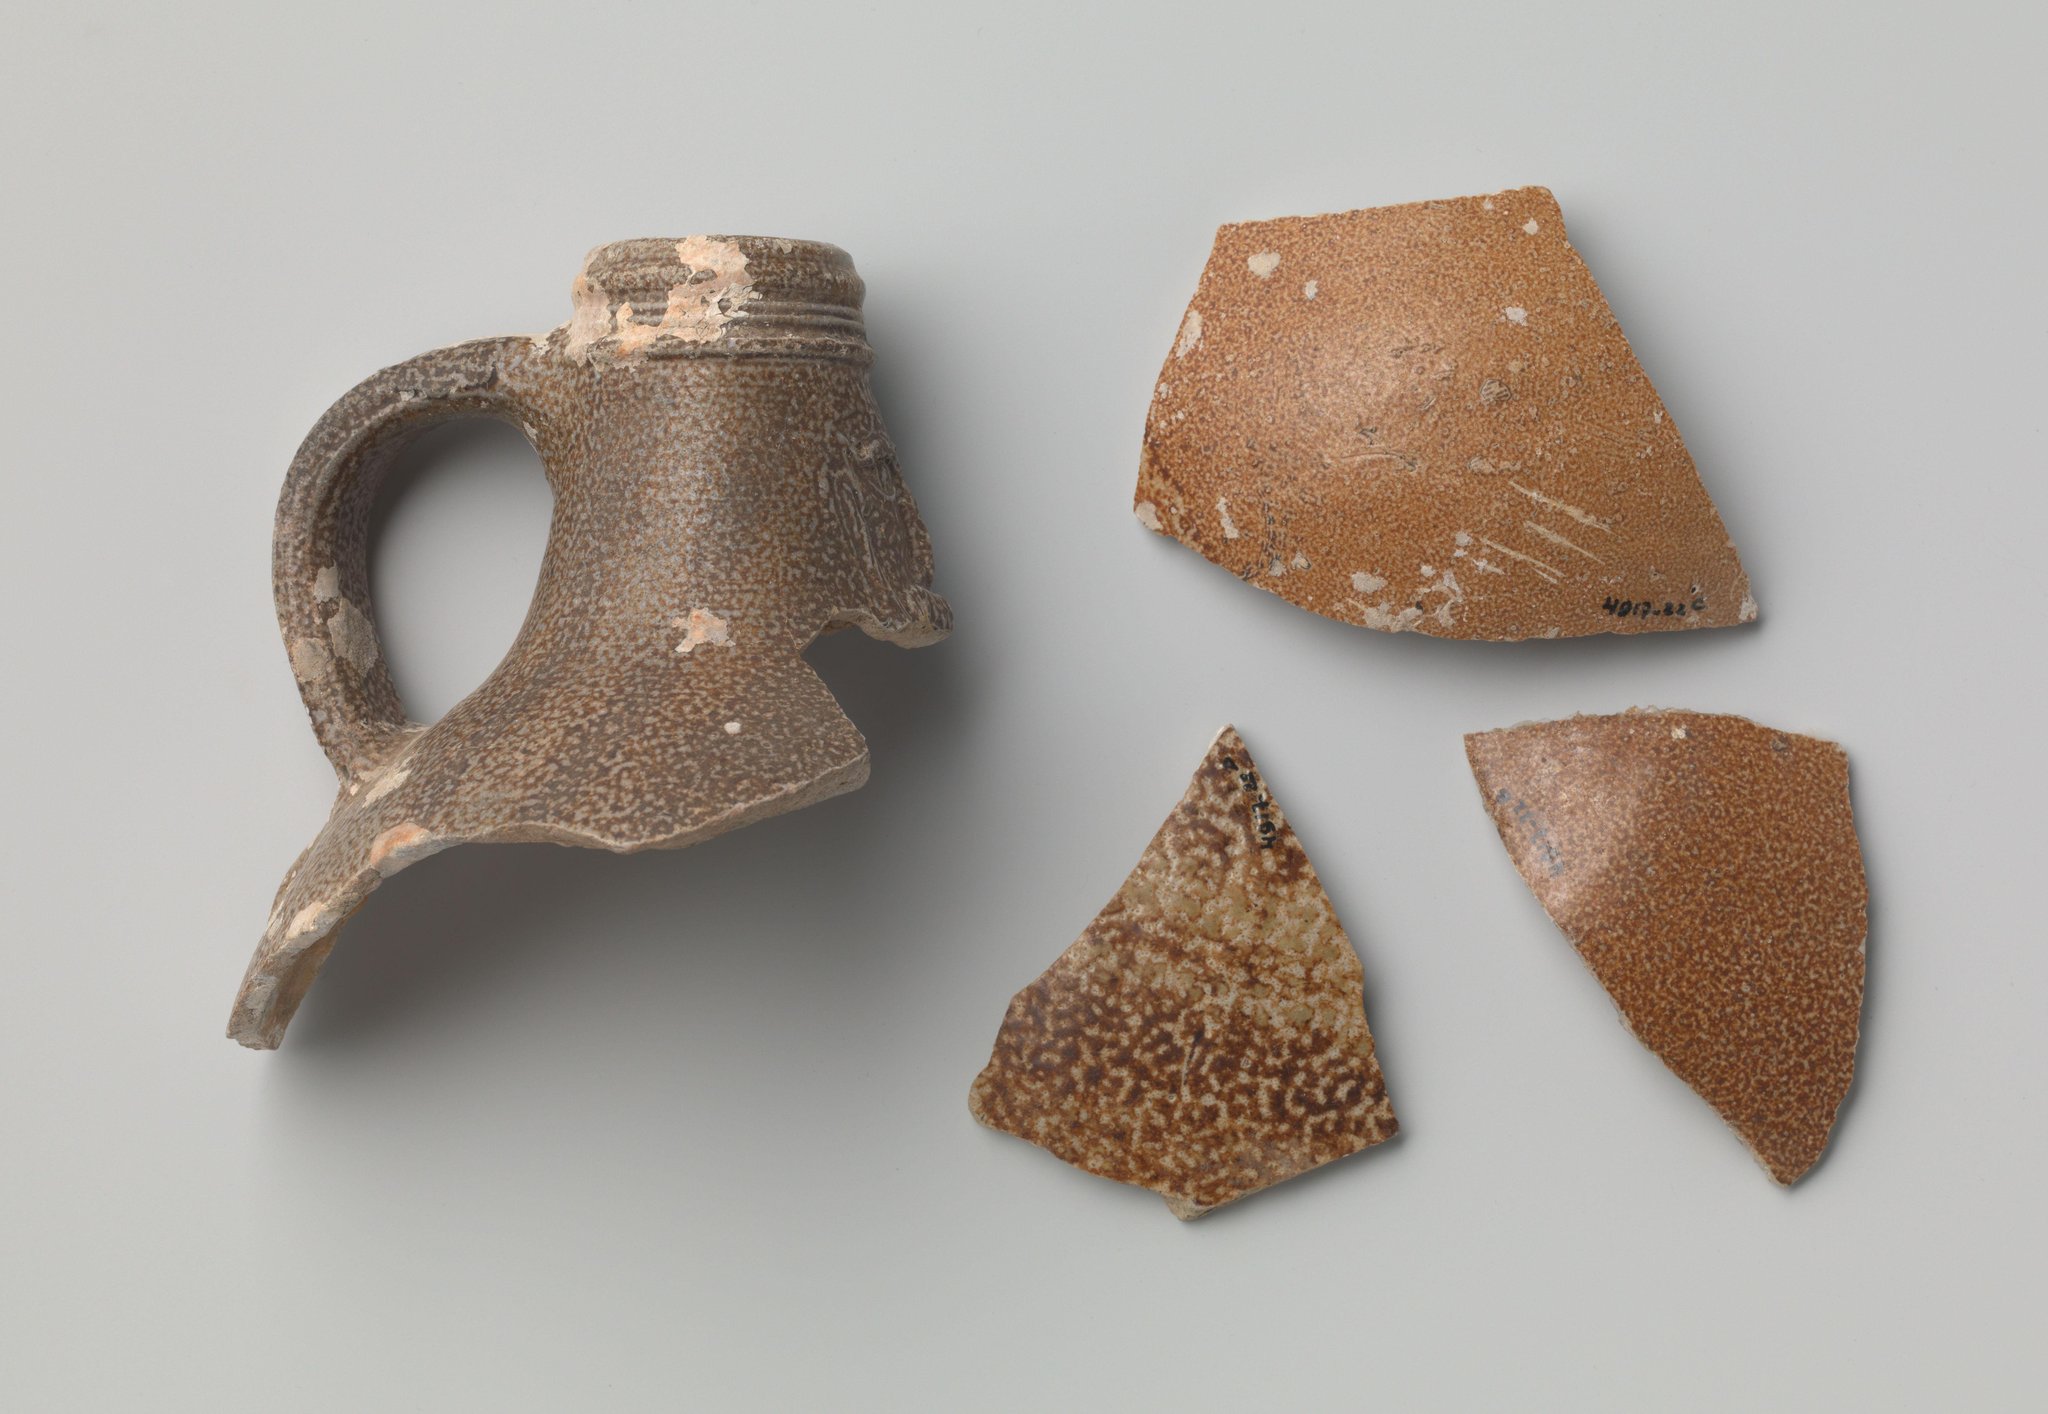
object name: bellarmine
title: Scherven van baardmankruiken uit het wrak van de Oostindiëvaarder Hollandia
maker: Anonymous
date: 1700-1743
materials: stoneware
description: Scherven van baardmankruiken, één van de mond, hals en oor, de andere drie scherven van de buik.